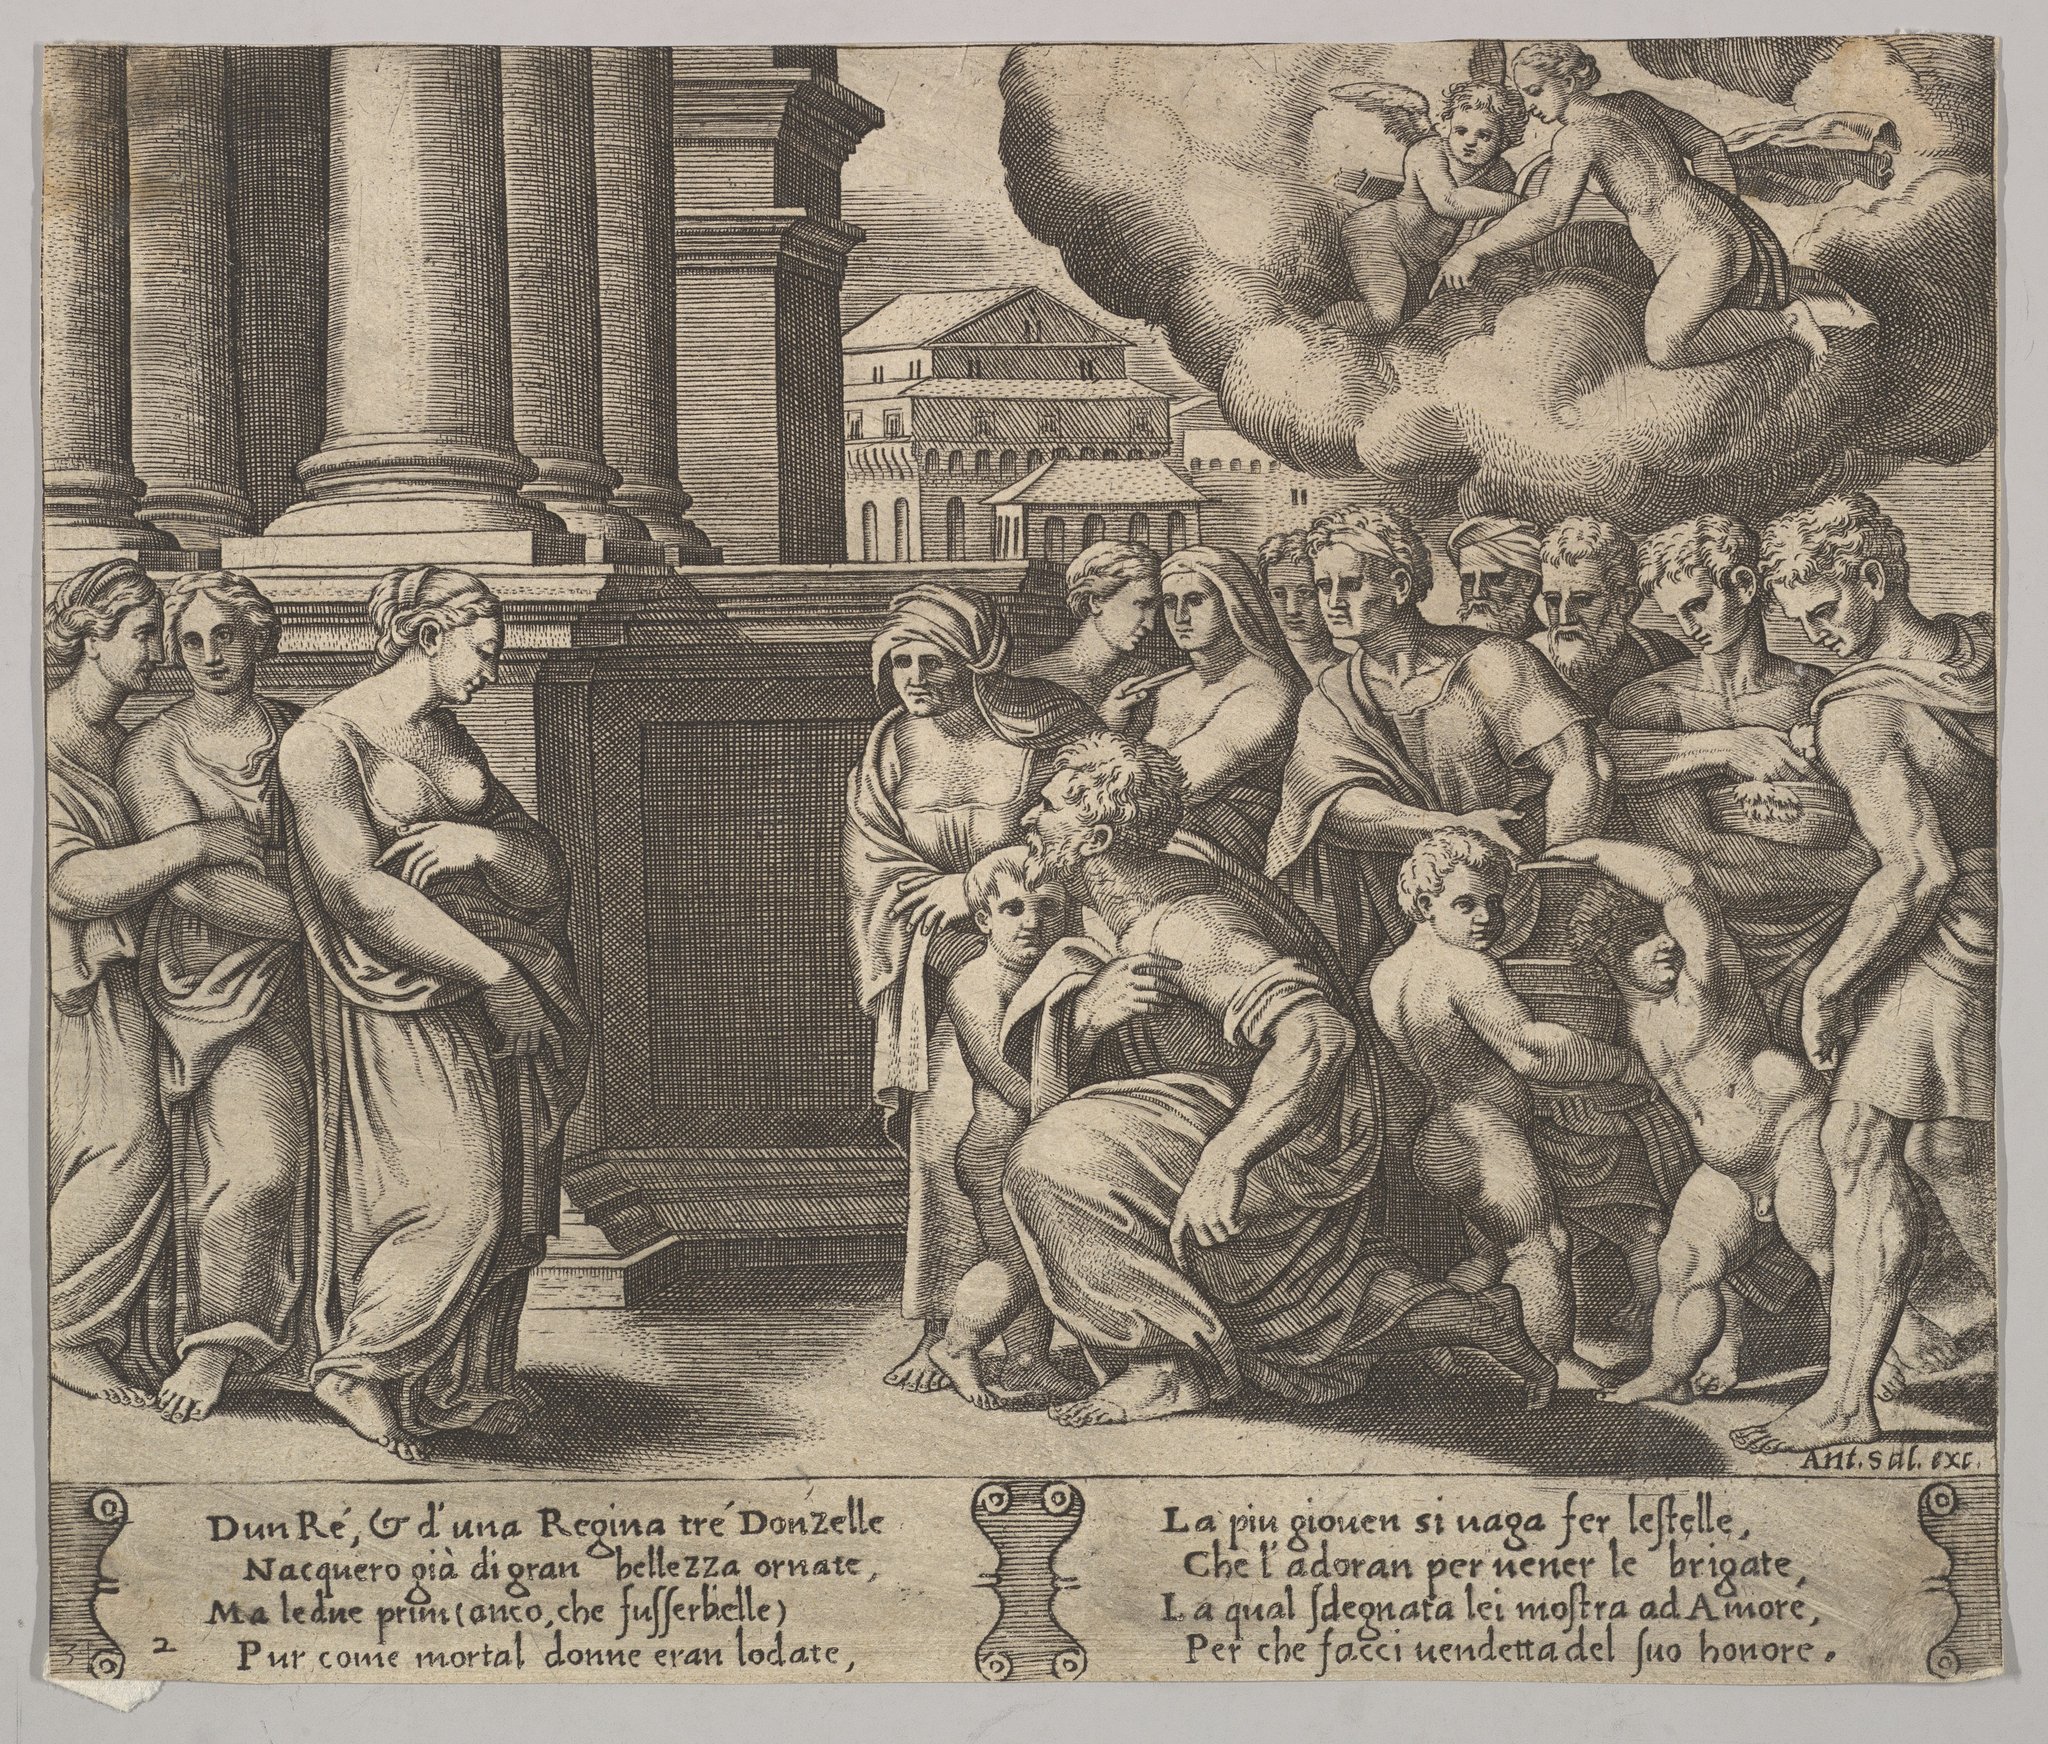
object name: print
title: Plate 2: the people rendering divine honors to Psyche, from "The Fable of Psyche"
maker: master of the die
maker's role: artist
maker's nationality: italian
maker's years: 1525-1560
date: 1530-1560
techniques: engraving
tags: men,women,psyche,putti